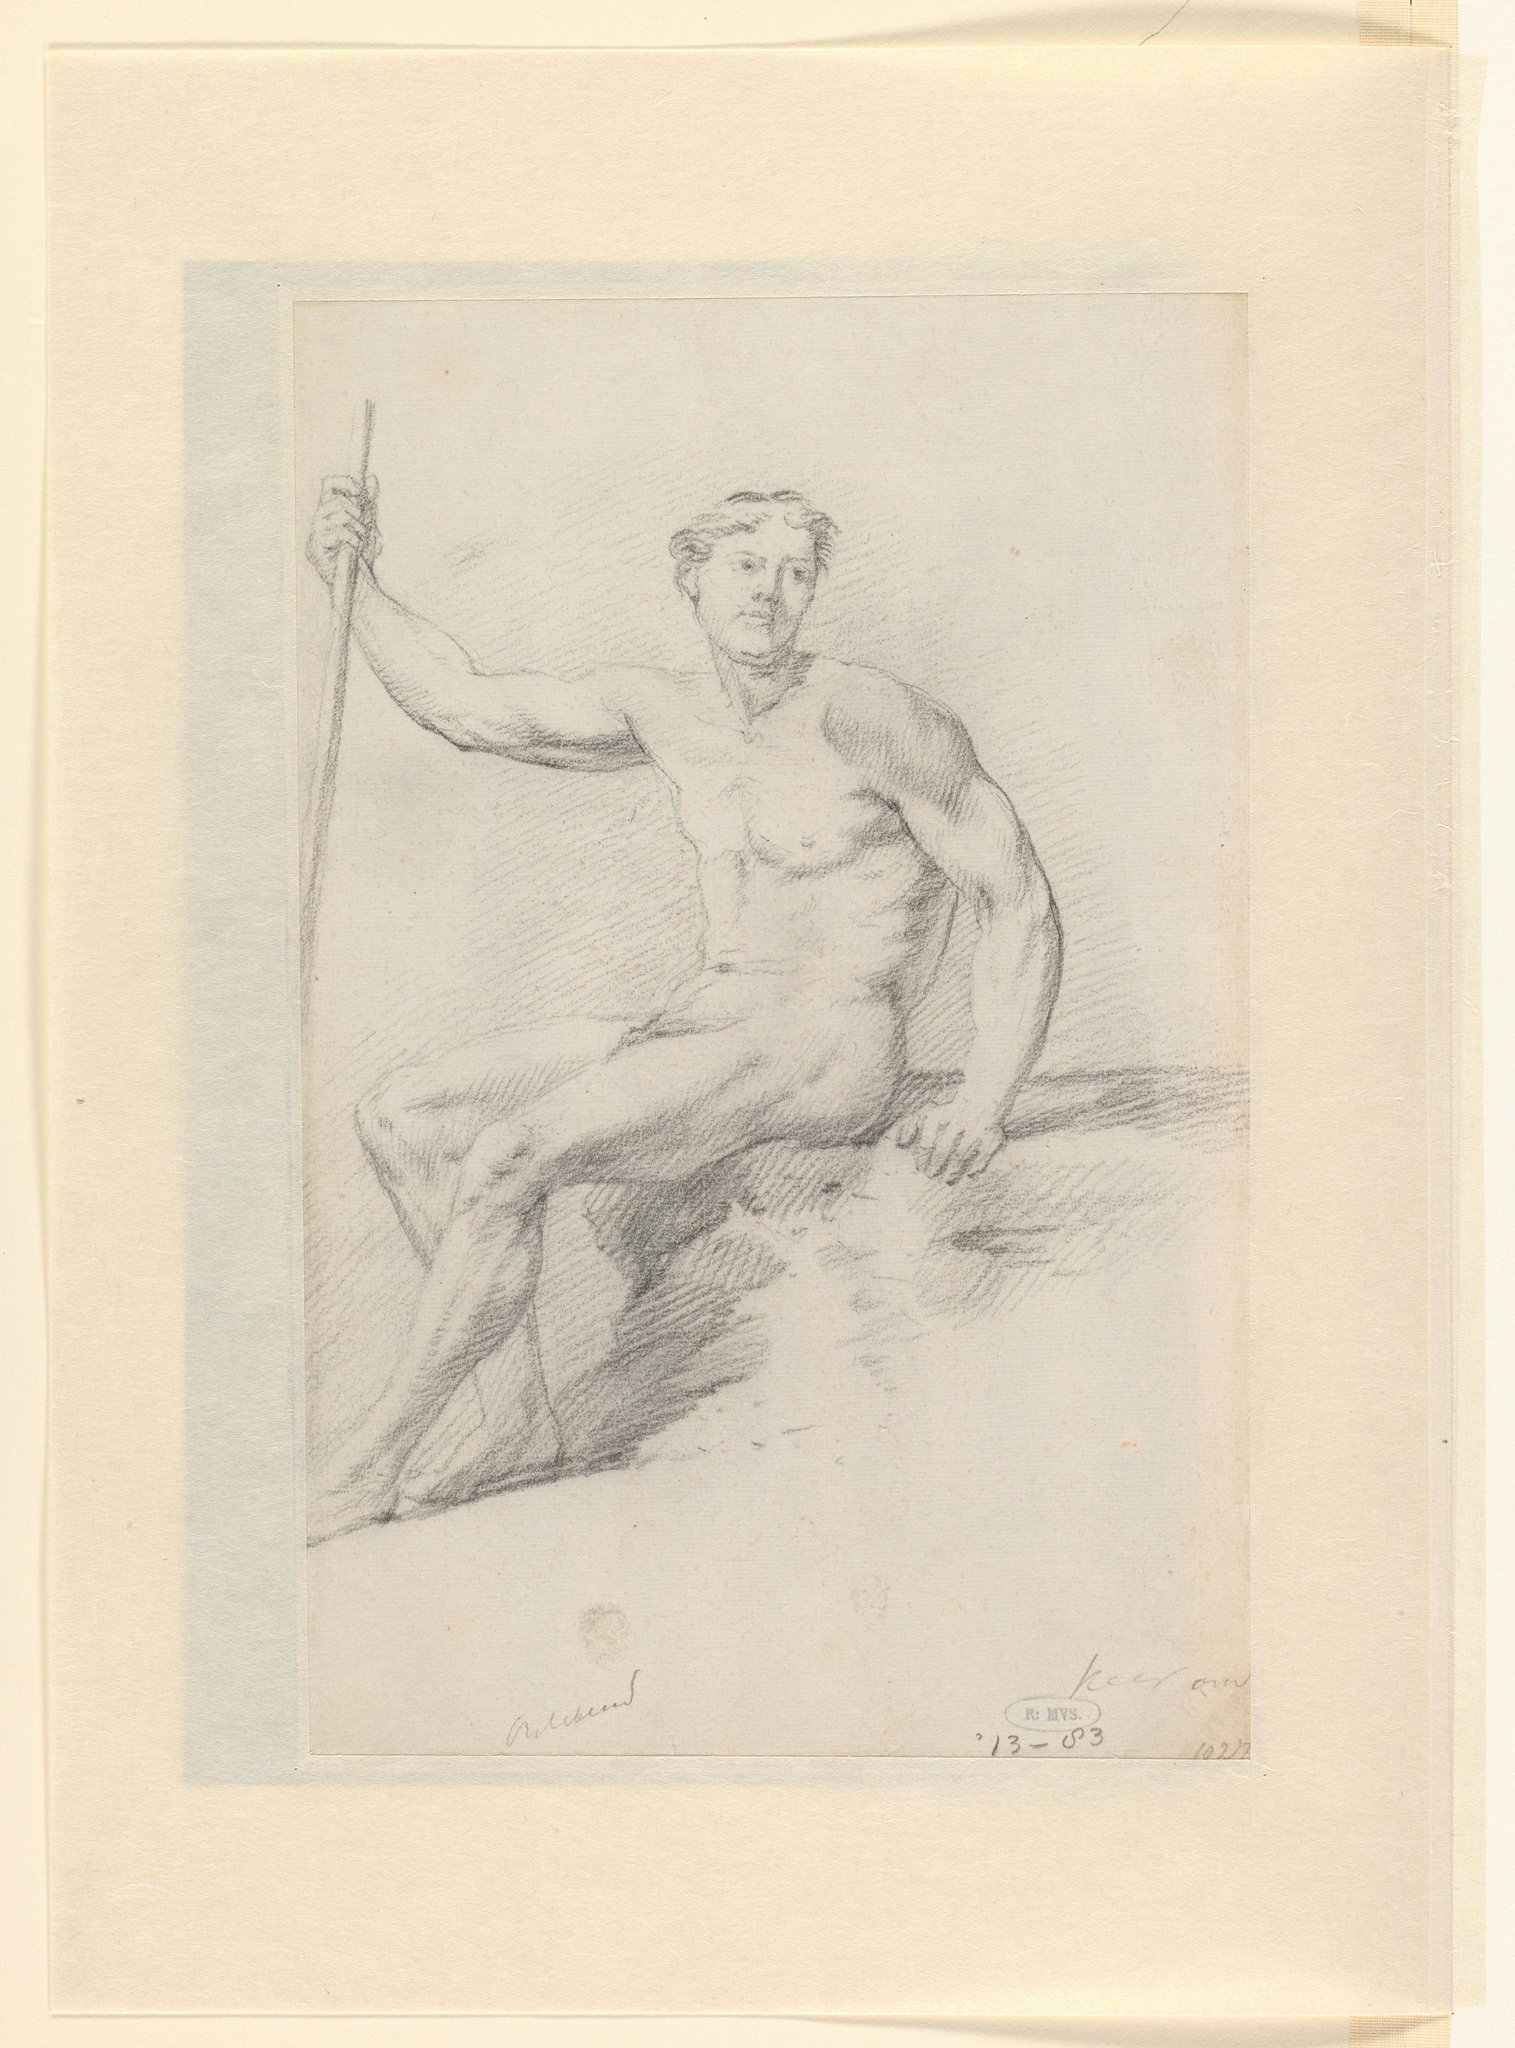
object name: drawing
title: Zittend mannelijk naakt met een stok in de hand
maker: jan hoogsaat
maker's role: painter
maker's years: 1654-1750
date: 1664-1730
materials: chalk, paper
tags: sitting figure, human figure of ideal proportions, e.g. academic nude